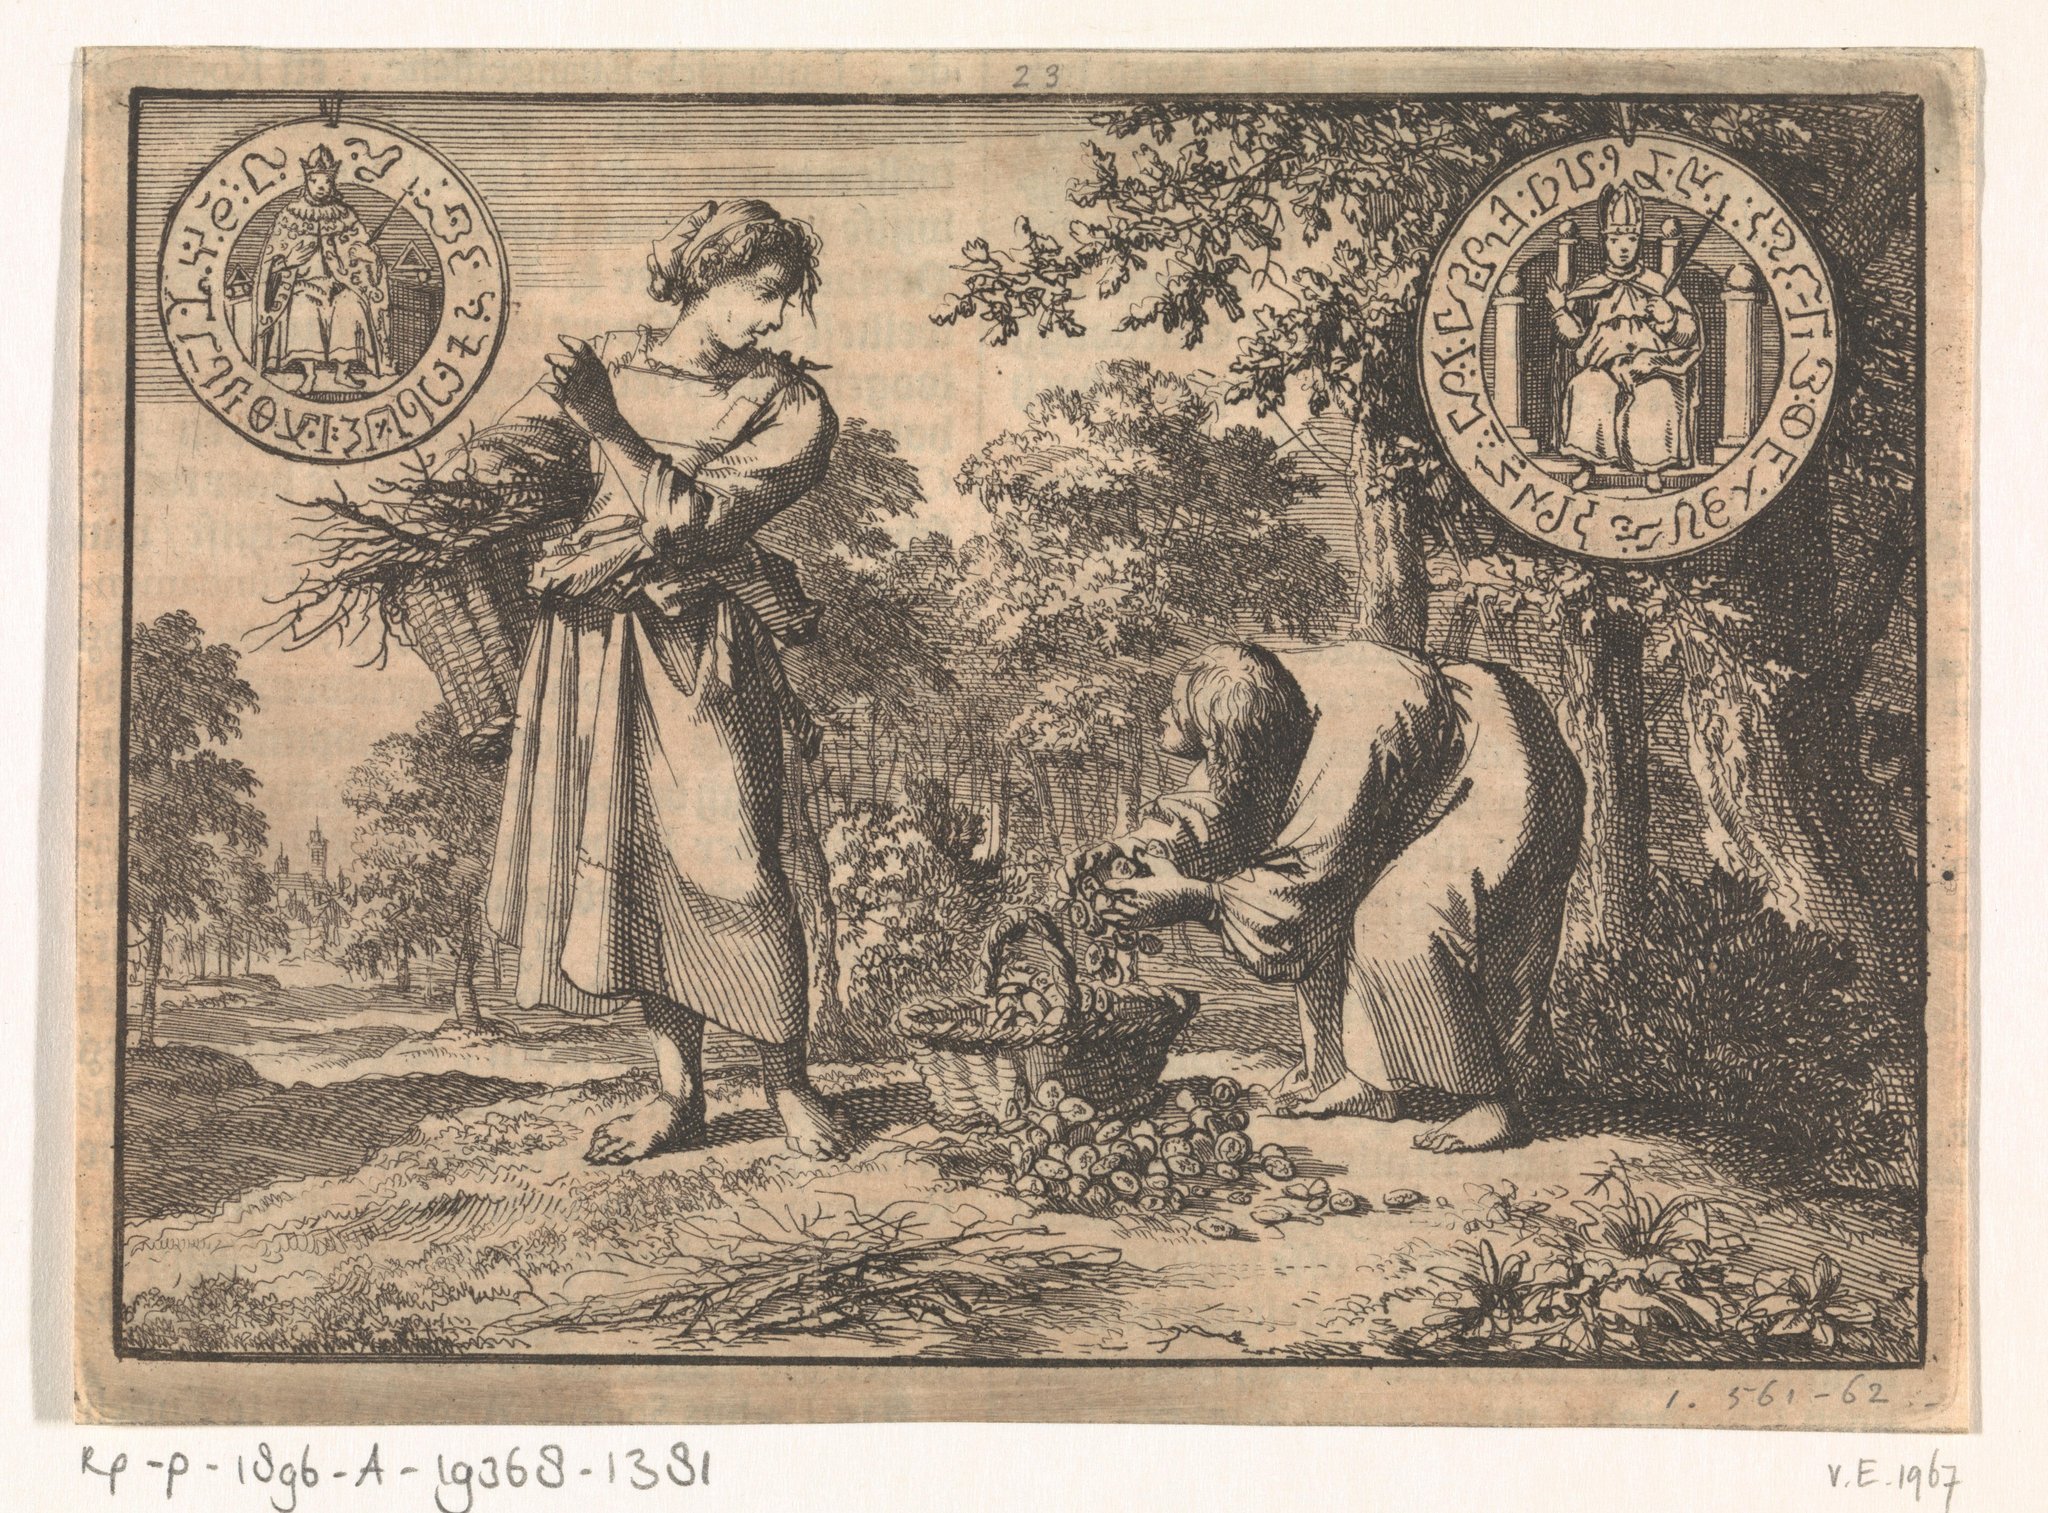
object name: book illustration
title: Wonderlijke verschijning van een oud mannetje aan een arm boerenmeisje, terwijl hij haar mand vult met zilveren munten, 1605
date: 1698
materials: paper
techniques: etching, letterpress printing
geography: leiden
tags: appearances, adolescent, young woman, maiden, container made of plant material other than wood: basket, old man, money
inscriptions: collector's mark: Lugt 2228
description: Illustratie uit: Gottfried, Johann Ludwig. Historische kronyck; vervattende een (...) beschrijvingh der aldergedenckwaerdigste geschiedenissen des weerelds, van den aenvangh der scheppingh tot (...) 1576 (2 delen). Leiden: Pieter van der Aa, 1698, dl. I, p. 561.